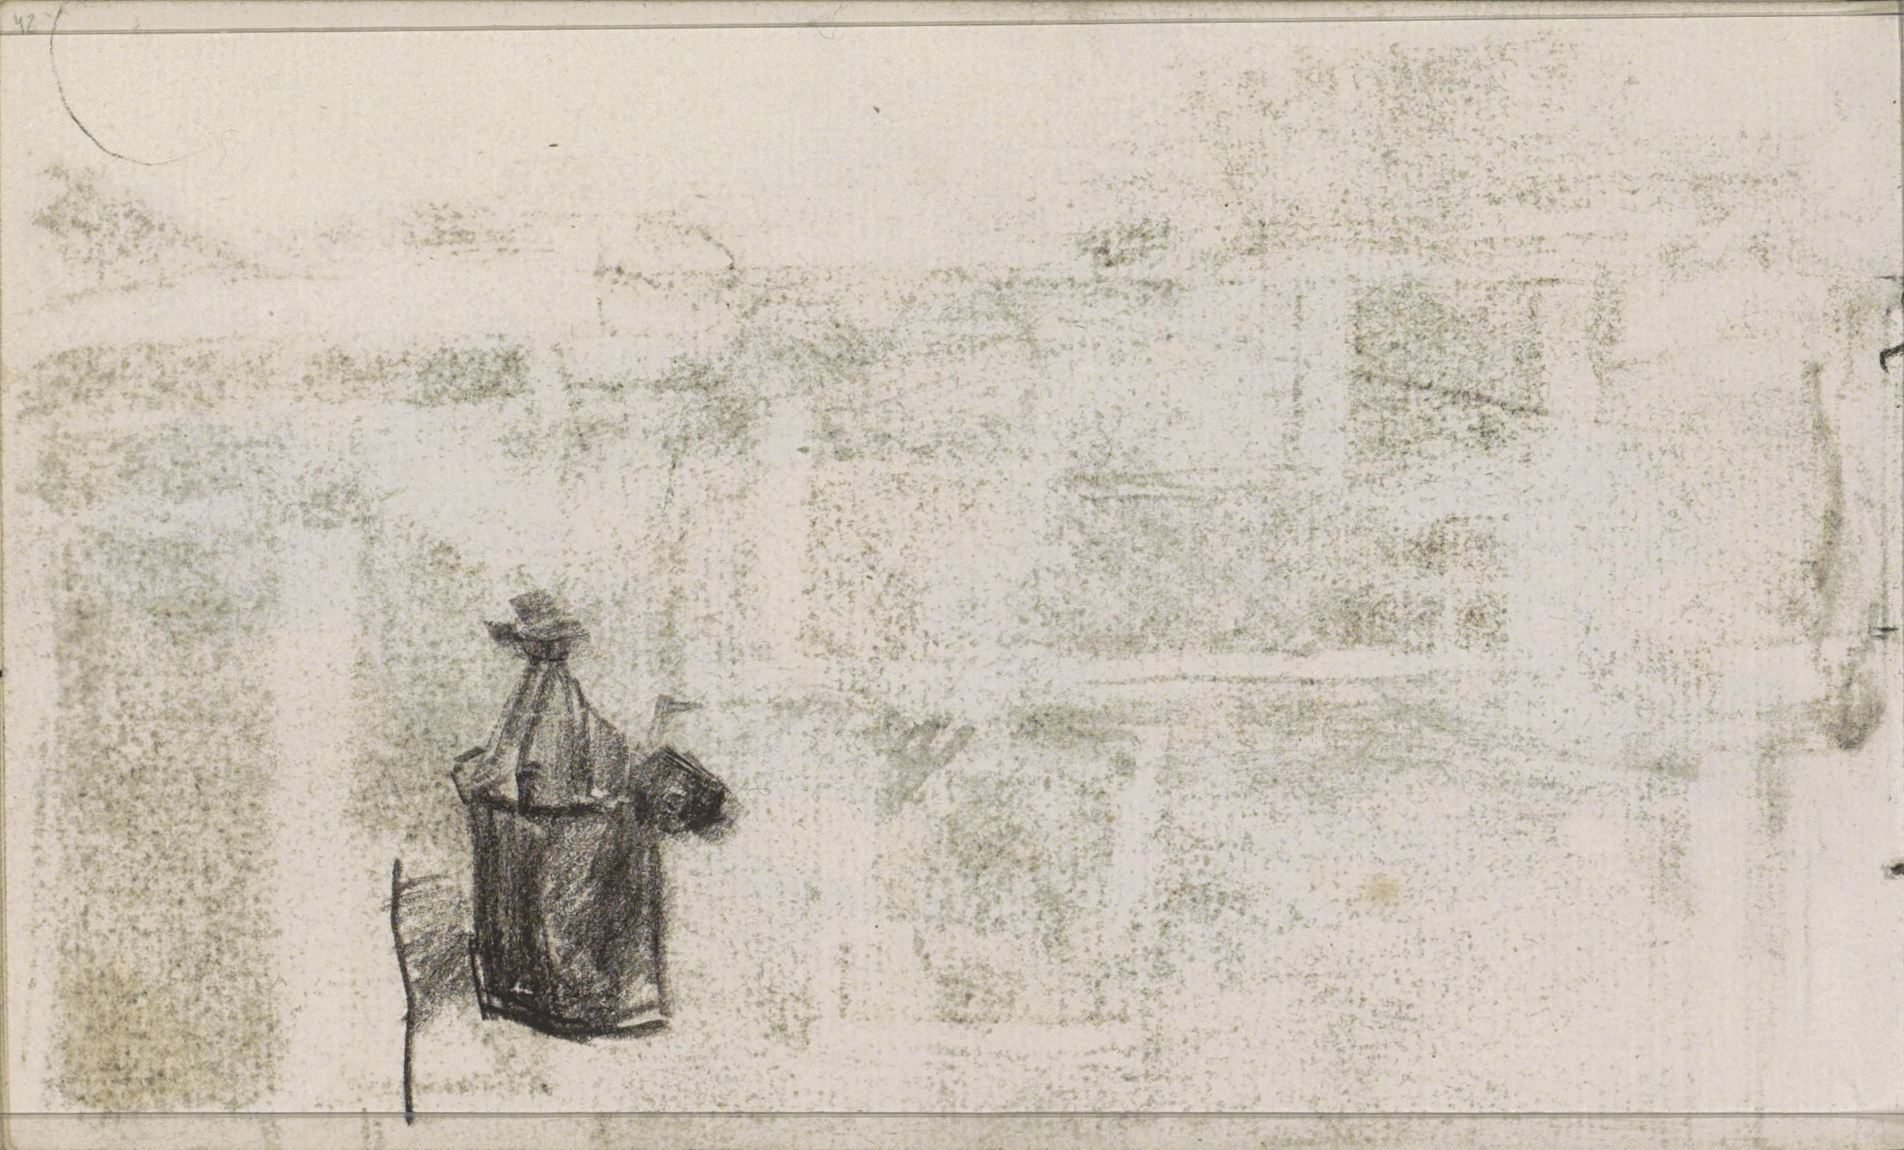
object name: sketchbook leaf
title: Figuur met hoed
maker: isaac israels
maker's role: draughtsman, painter, print maker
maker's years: 1865-1934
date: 1875-1934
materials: chalk, paper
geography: the hague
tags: the (nude) human figure; 'corpo humano' (ripa), head-gear: hat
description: Mogelijk met een stuk stof in de handen. Pagina 42 uit schetsboek XLVIII met 62 pagina's.